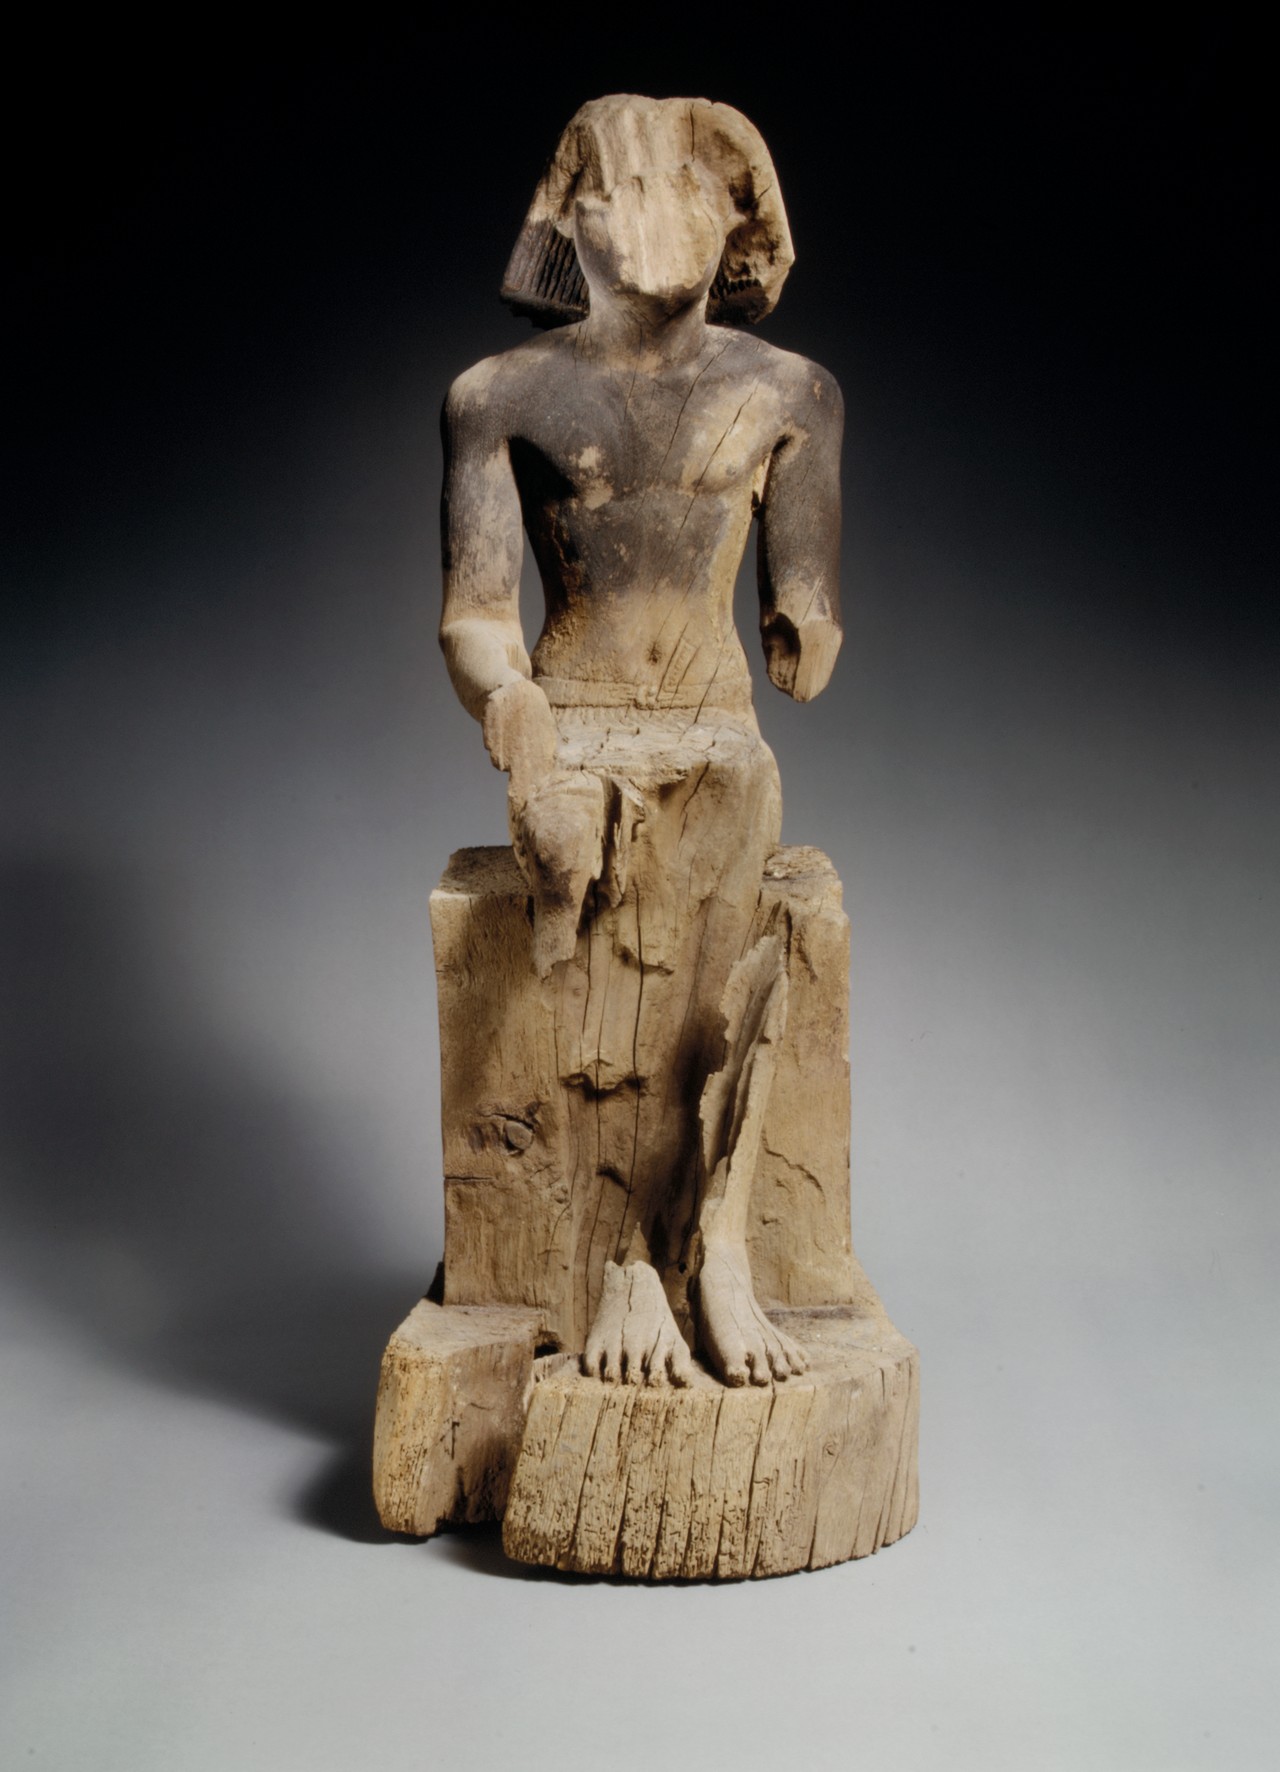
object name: statuette, man sitting, kaemsenu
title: Sitting Statue of Kaemsenu (?)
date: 2420-2389 BCE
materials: wood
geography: egypt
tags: men